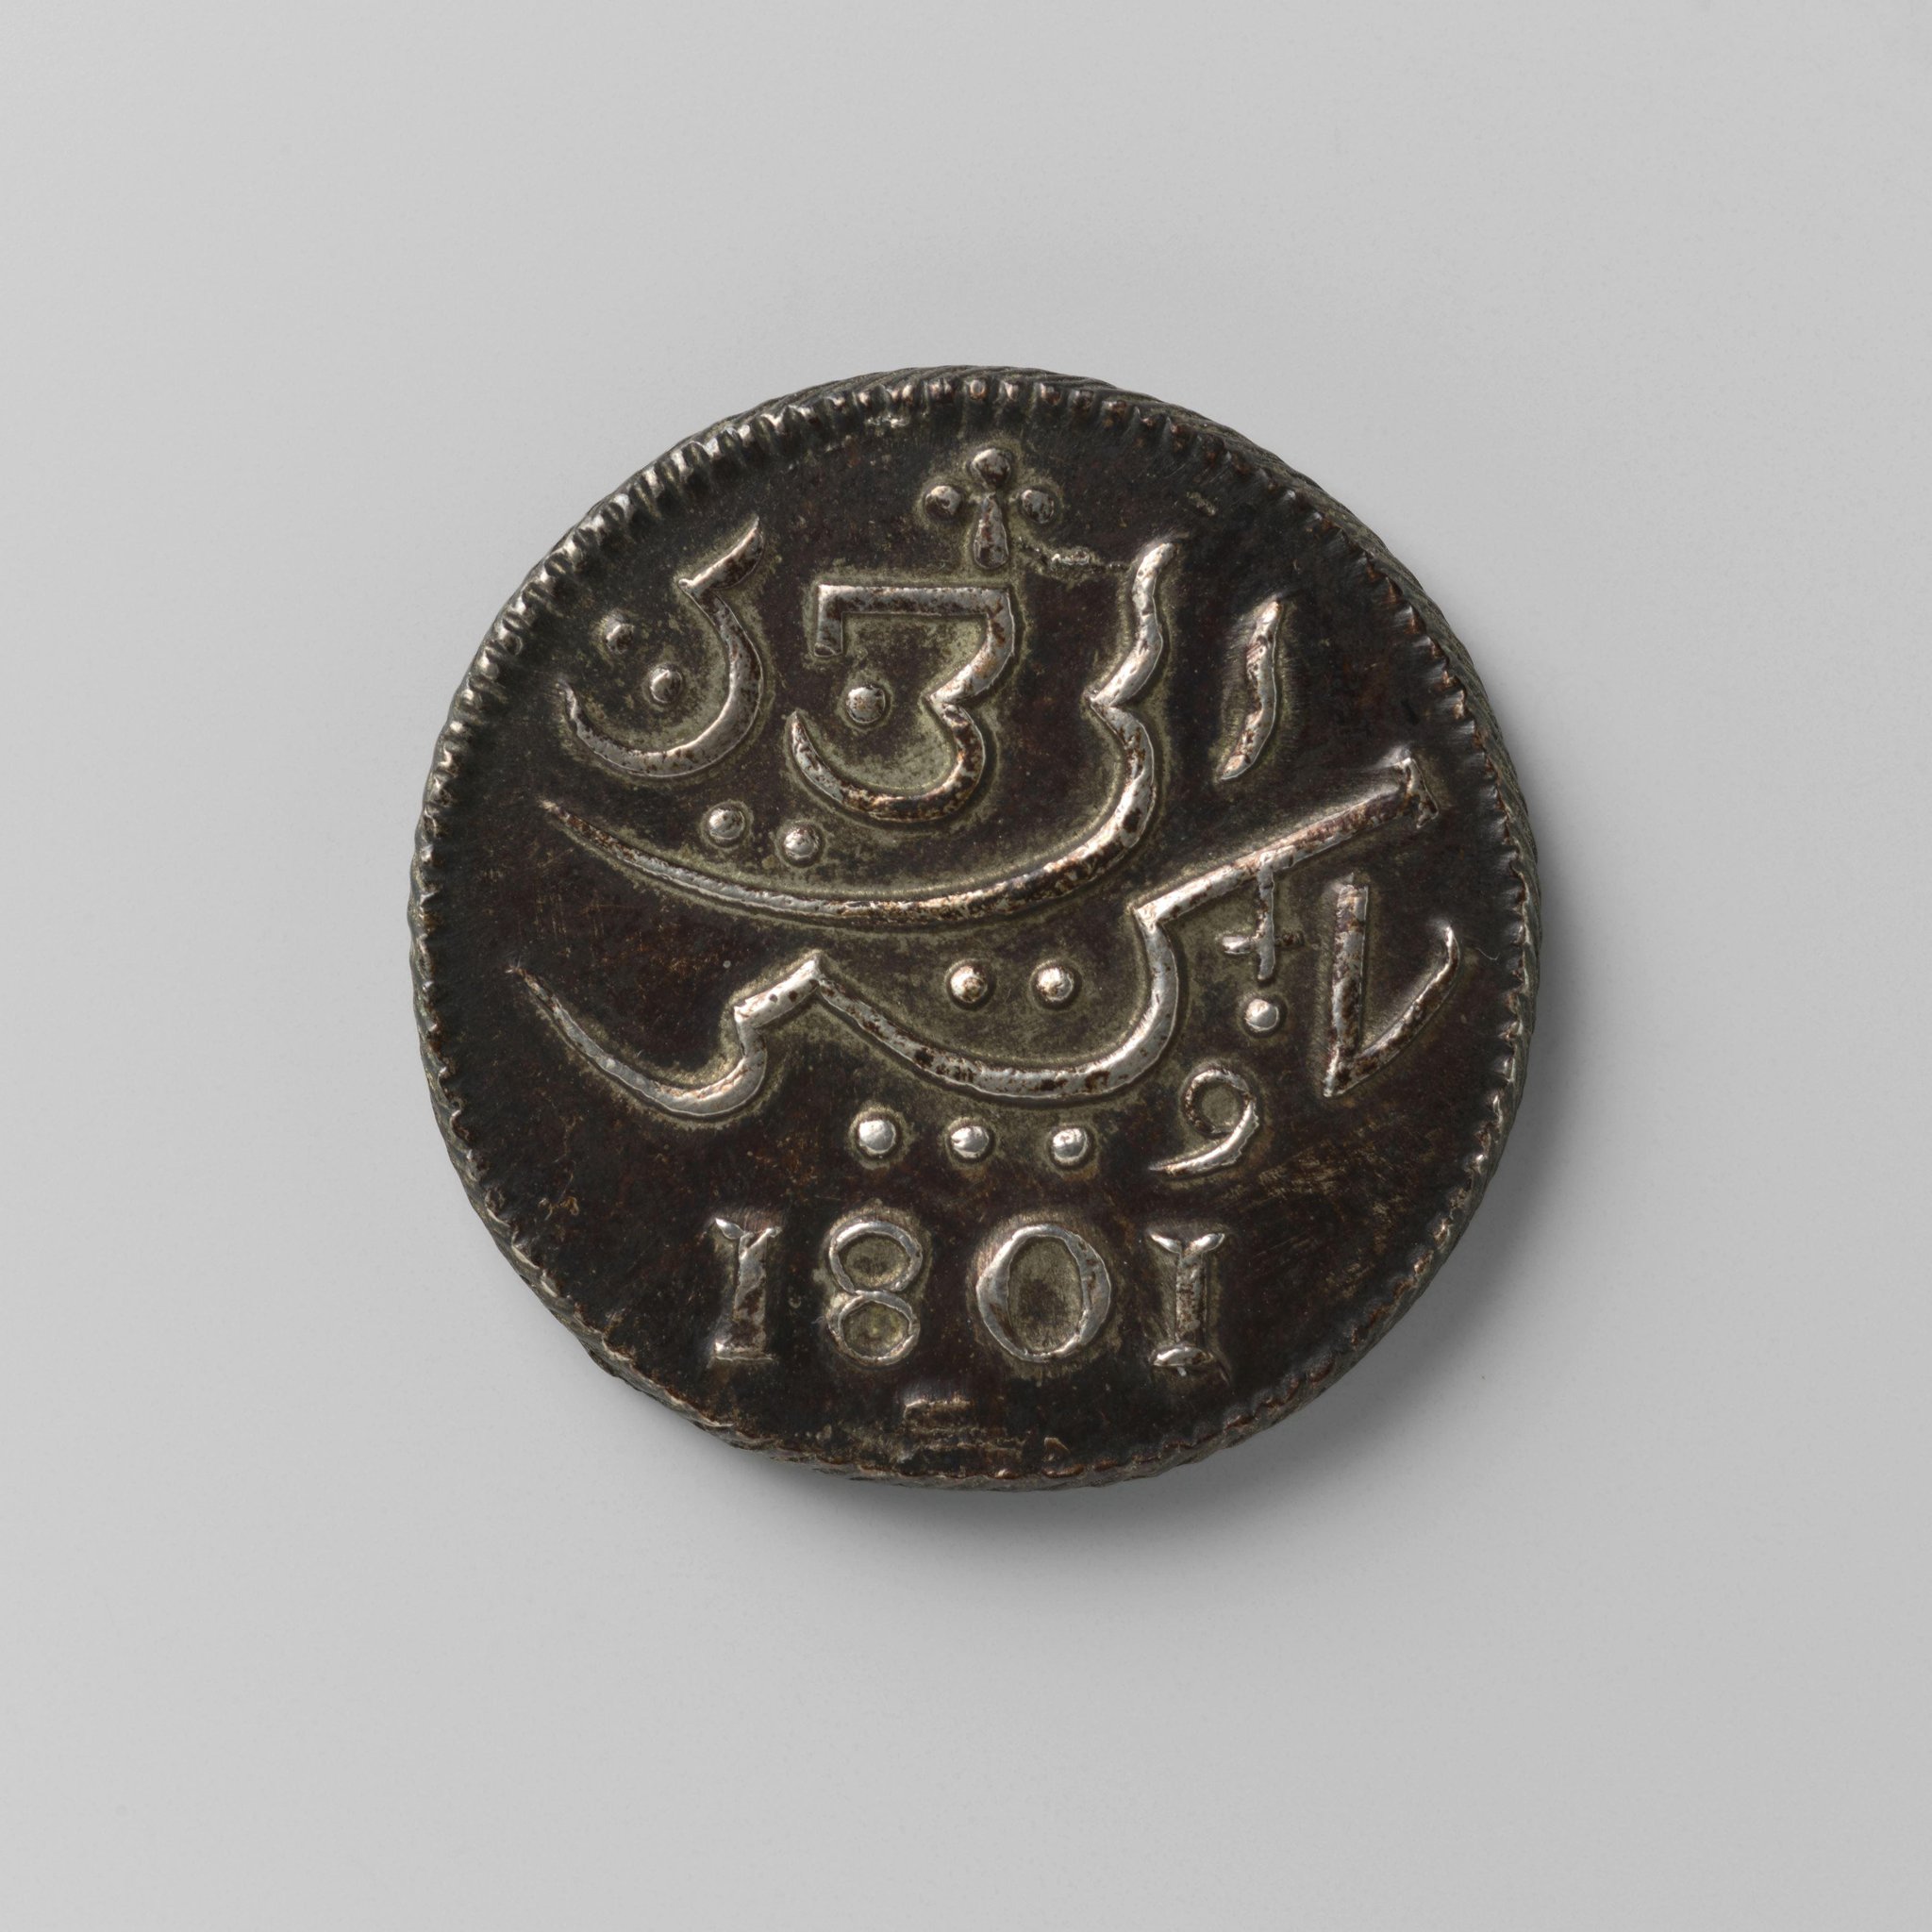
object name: coin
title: Zilveren ropij van Nederlands Indië uit Java, 1801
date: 1801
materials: silver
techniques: striking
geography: batavia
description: Zilveren munt. Voorzijde: tweeregelig opschrift in Arabische letters. Daarboven muntteken en daaronder jaartal, waaronder muntmeesterteken Z [=muntmeester Zwekkert]. Keerzijde: drieregelig opschrift in Arabische letters. Kabelrand.